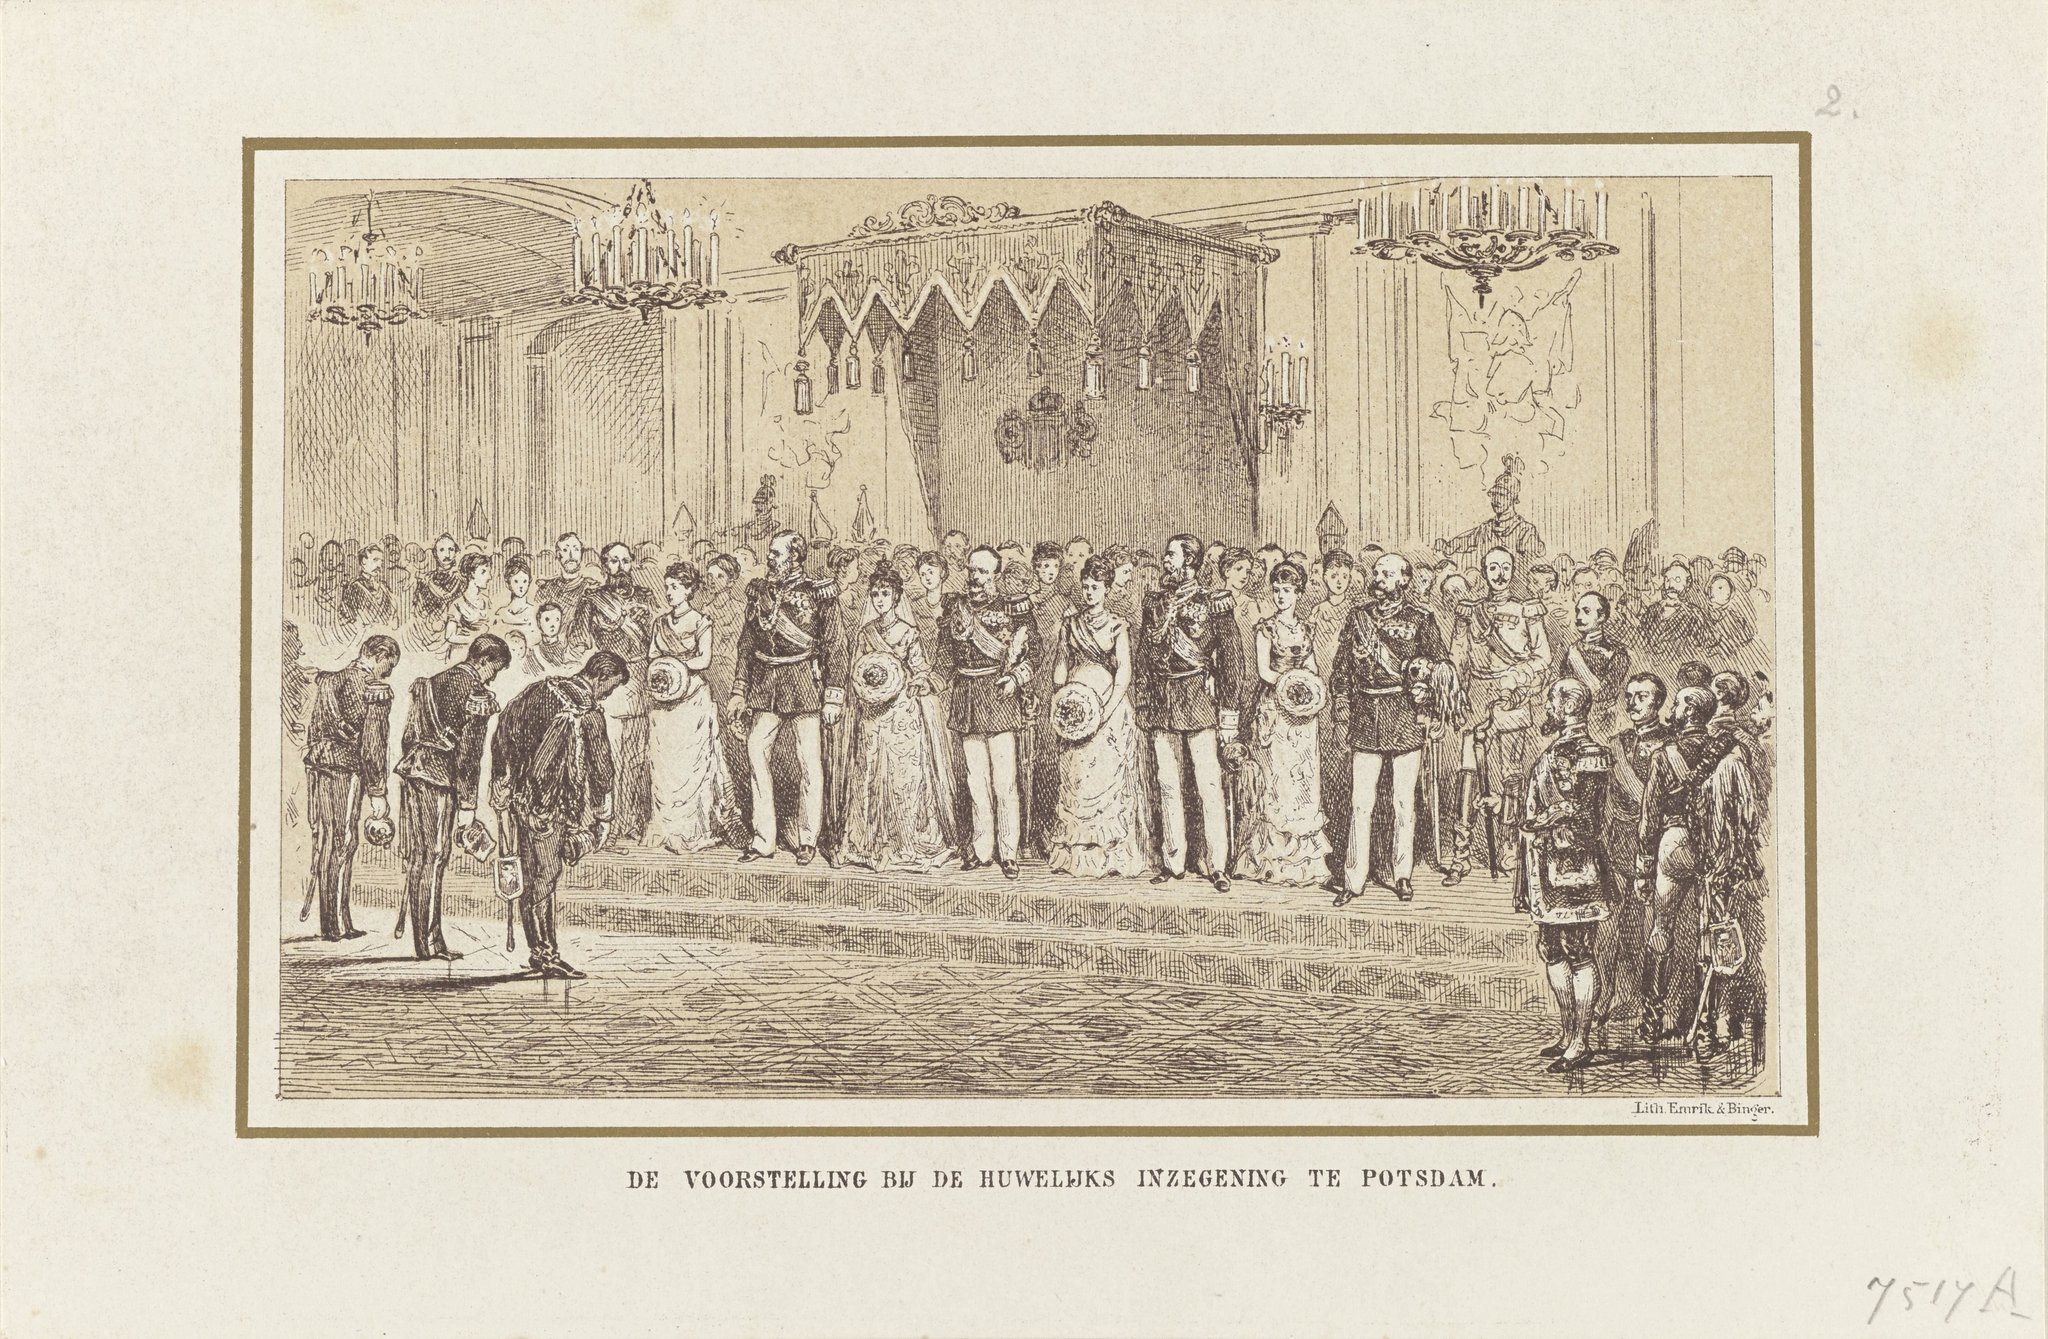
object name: print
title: De voorstelling bij de huwelijks inzegening te Potsdam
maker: Anonymous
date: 1879-1880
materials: paper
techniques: tone lithography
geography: netherlands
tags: hendrik (prins der nederlanden), civil marriage ceremony, bride and groom in wedding-dress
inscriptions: collector's mark: Lugt 2228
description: De inzegening van het huwelijk van Prins Hendrik en Prinses Maria van Pruisen te Potsdam op 24 augustus 1878. Onderdeel van het souvenir bij het huwelijk op 24 augustus 1878 bestaande uit een reeks van acht prenten plus een begeleidend boekje.